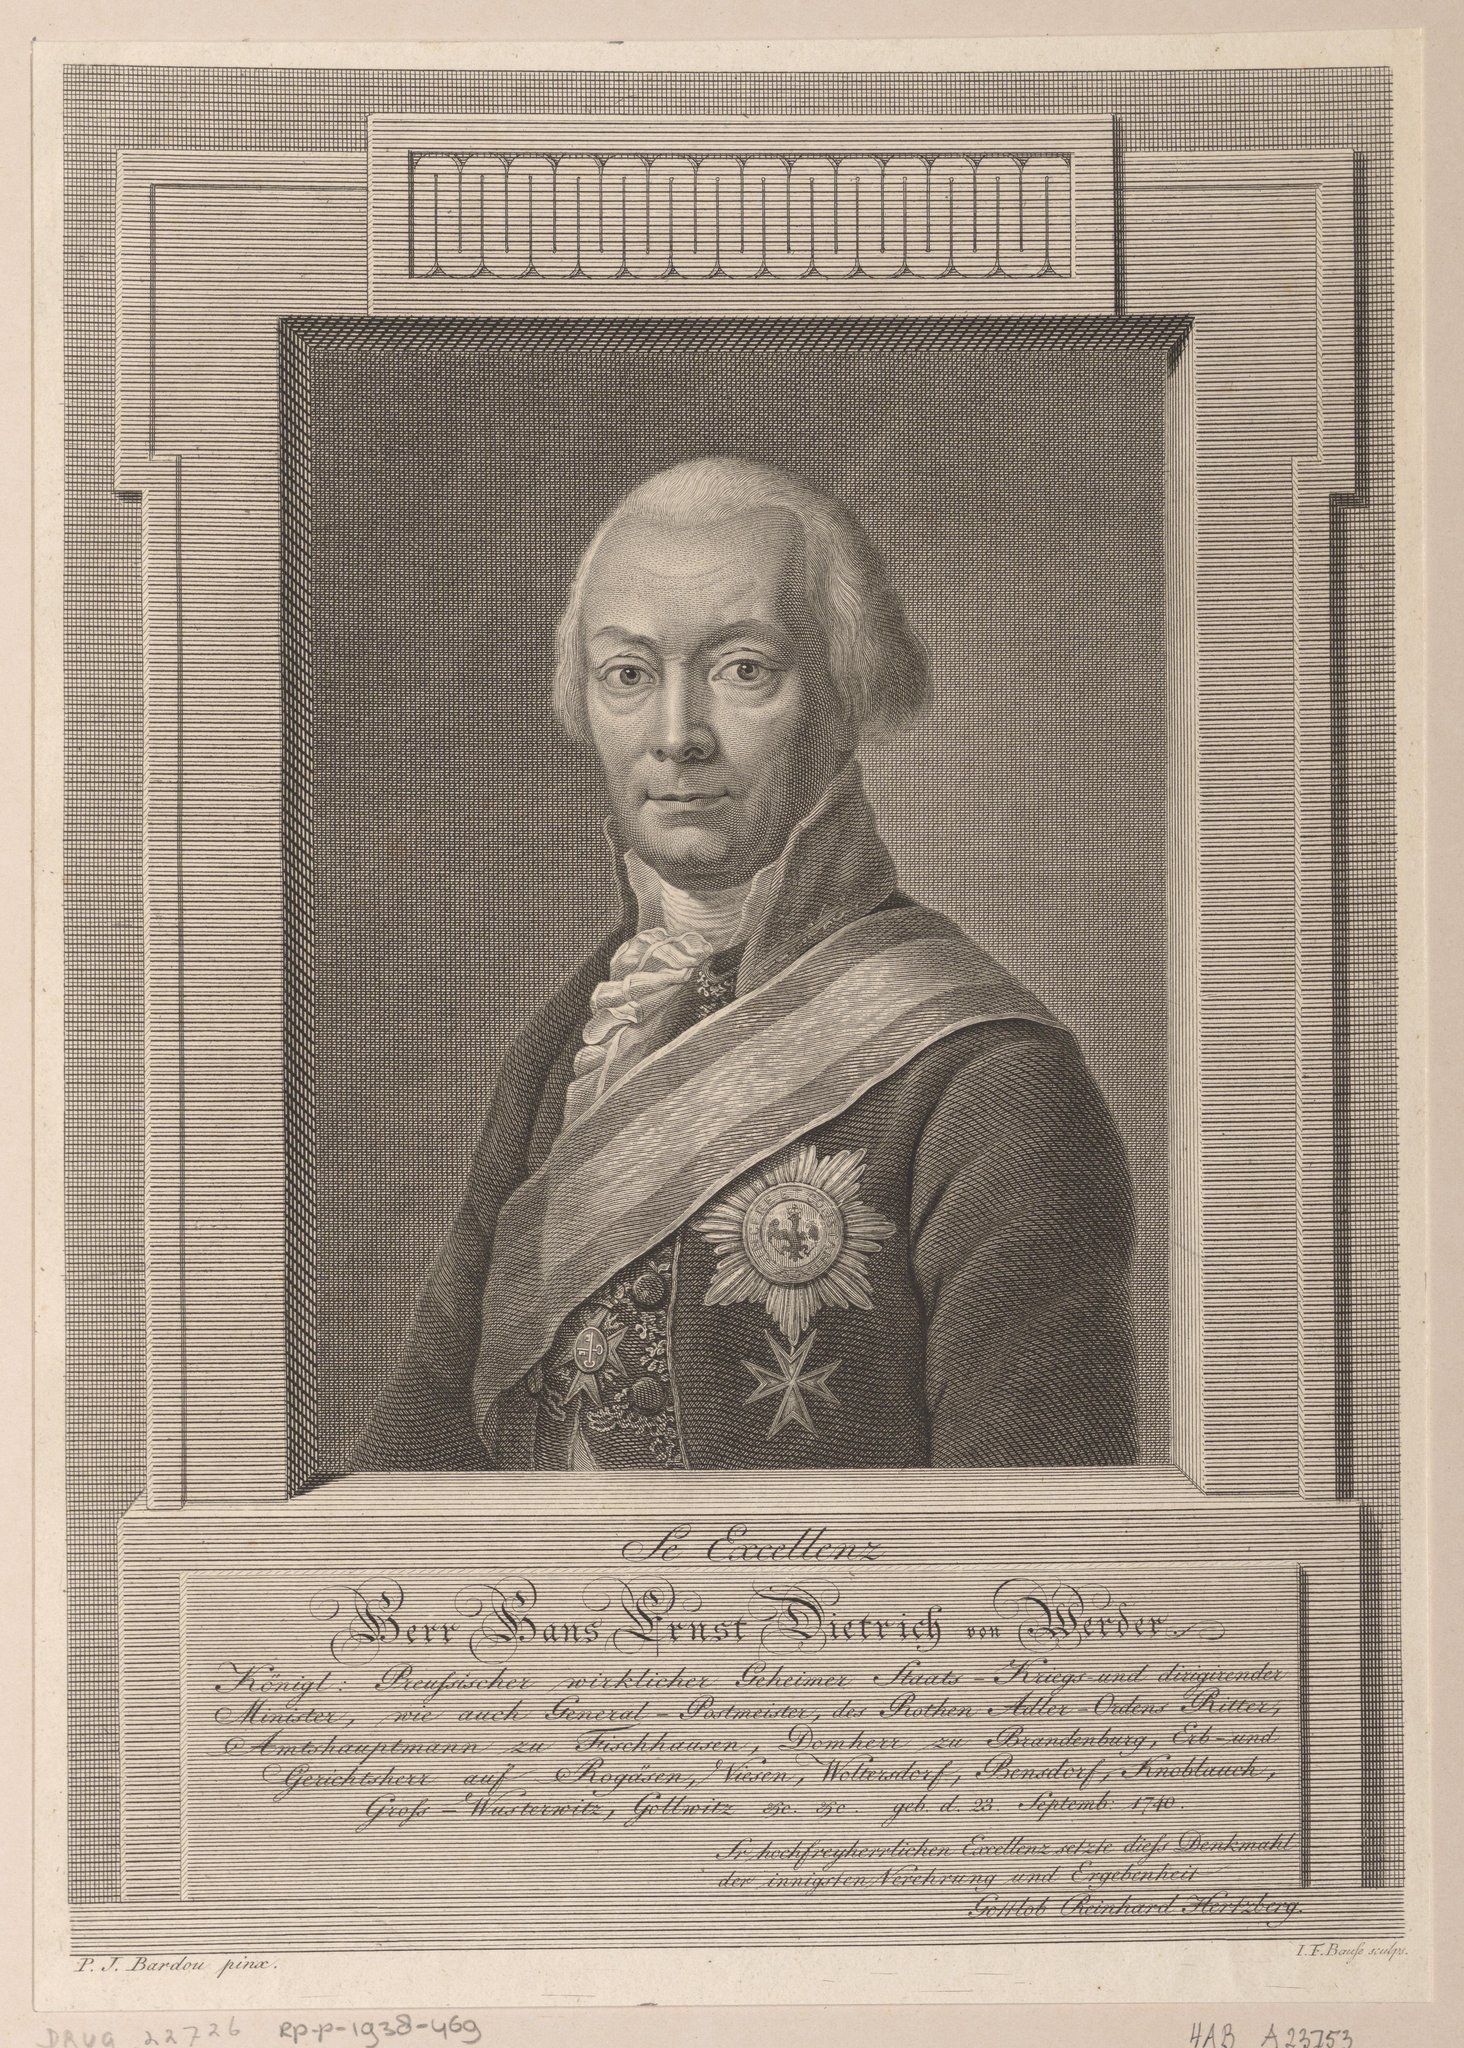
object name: print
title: Portret van Hans Ernst Dietrich von Werder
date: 1796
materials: paper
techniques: engraving, etching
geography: leipzig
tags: berlin, hans ernst dietrich von werder, historical persons, medals and other marks of military honour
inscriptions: collector's mark: Lugt 2228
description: Met zevenregelig onderschrift in het Duits.